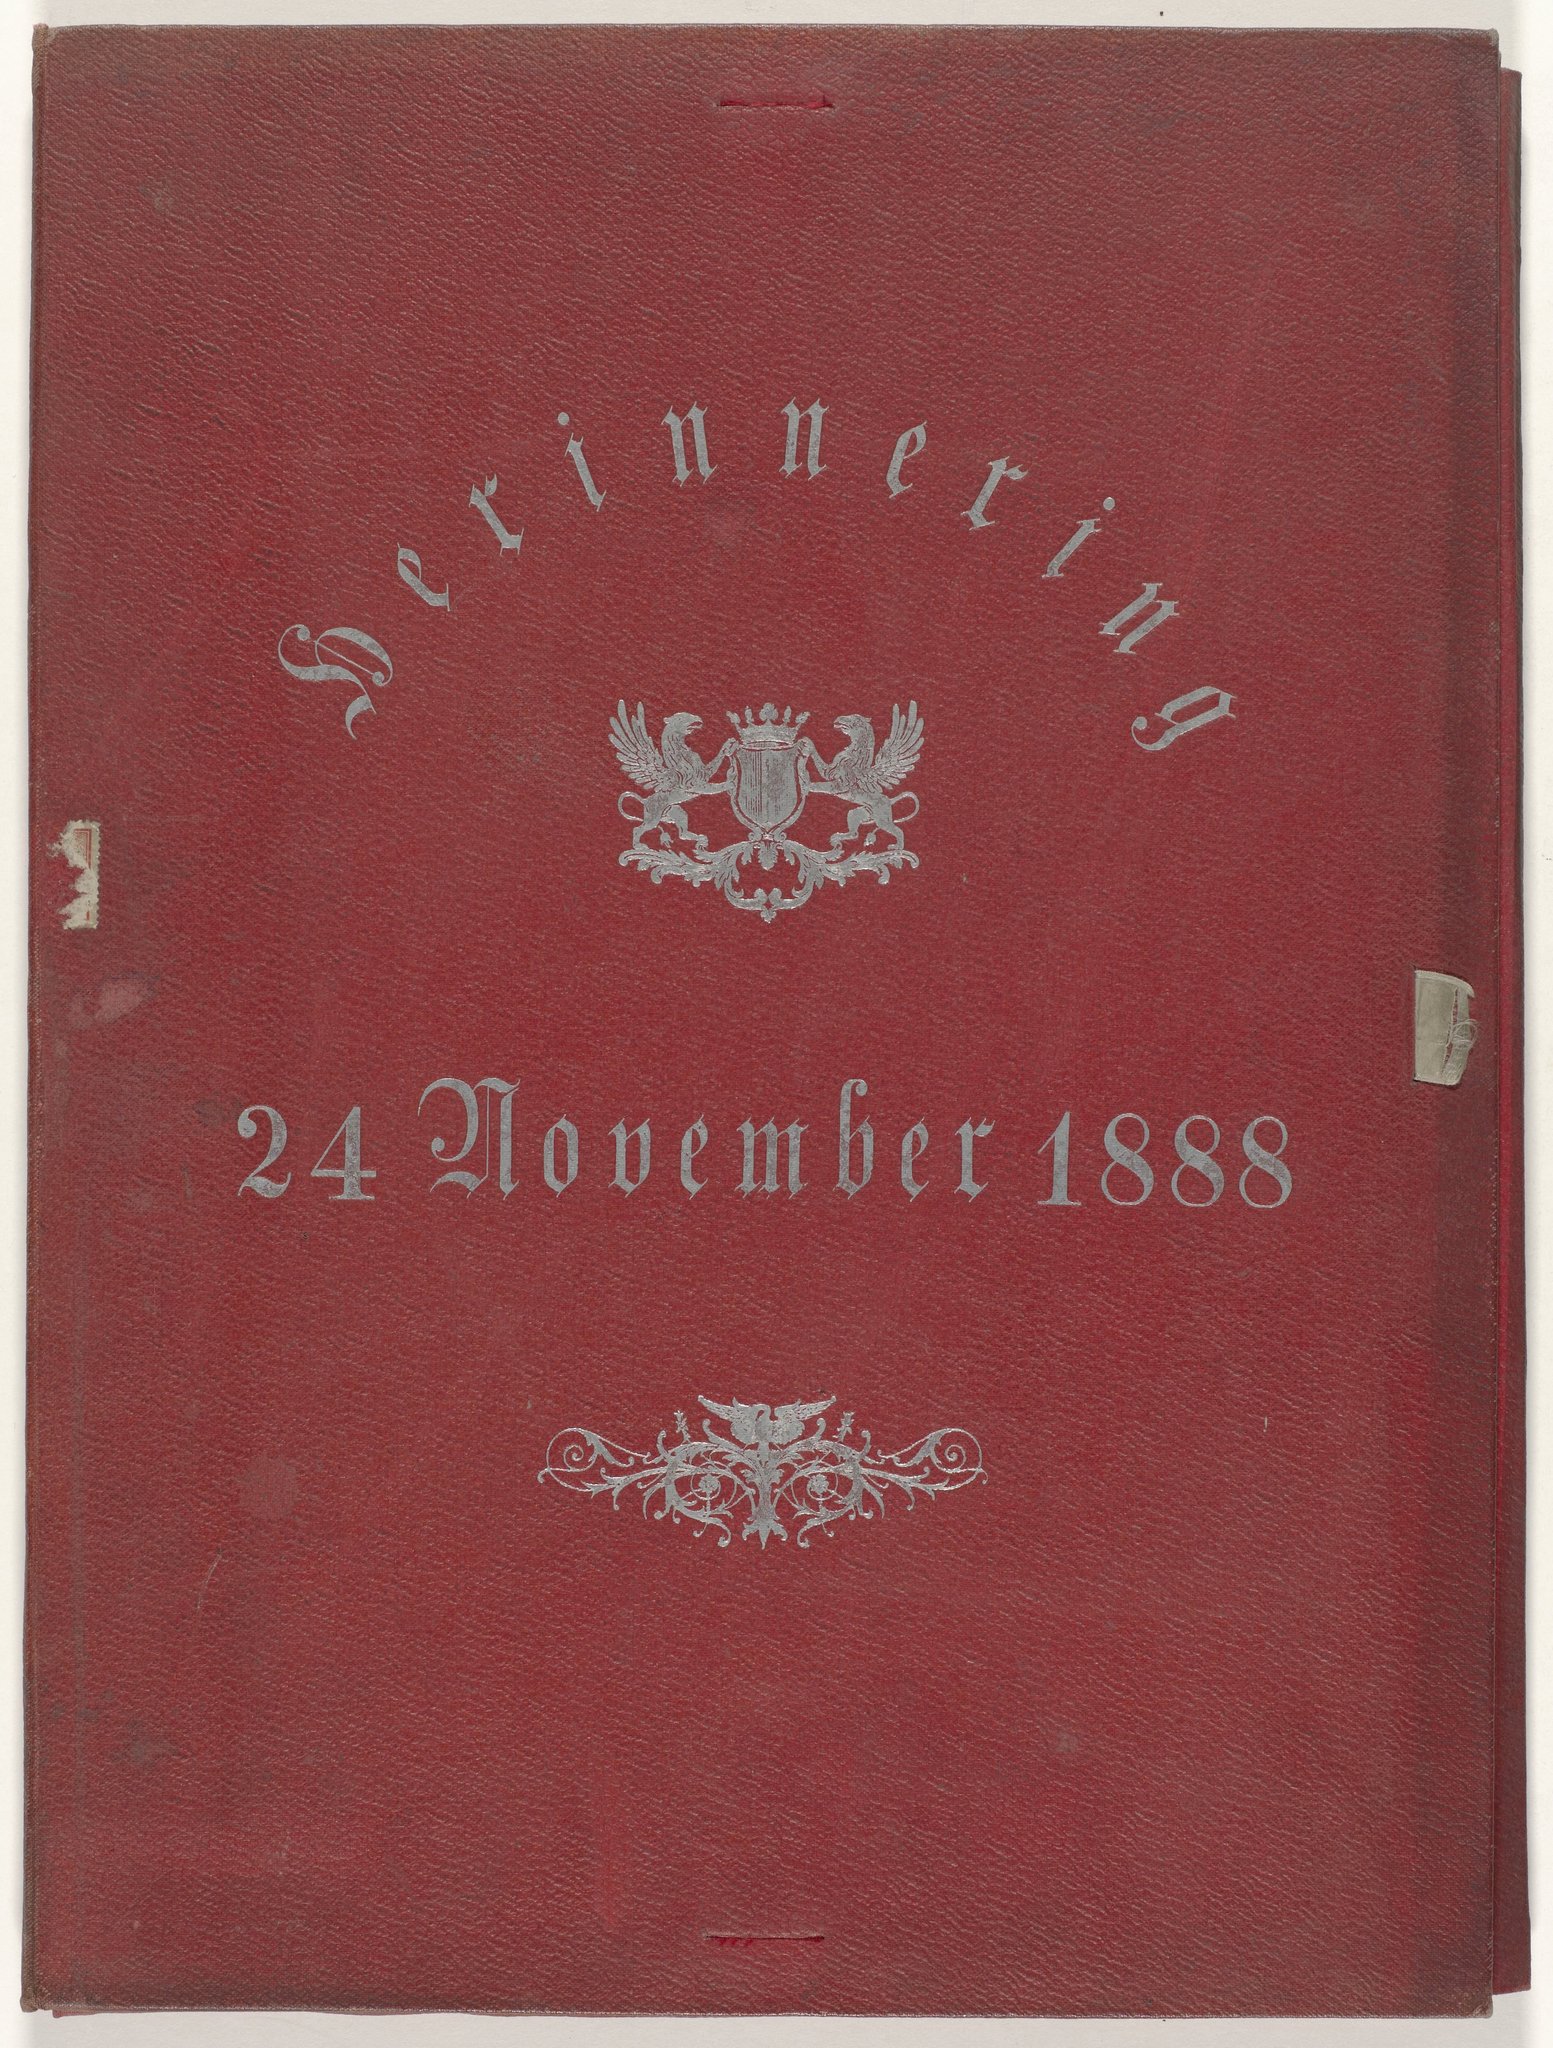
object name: photograph album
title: Herinnering, 24 november 1888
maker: s.m. hugo van gijn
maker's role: politician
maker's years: 1848-1937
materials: cardboard, paper, textile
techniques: printing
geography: dordrecht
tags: other festivities connected to calendar dates; memorial days, dordrecht